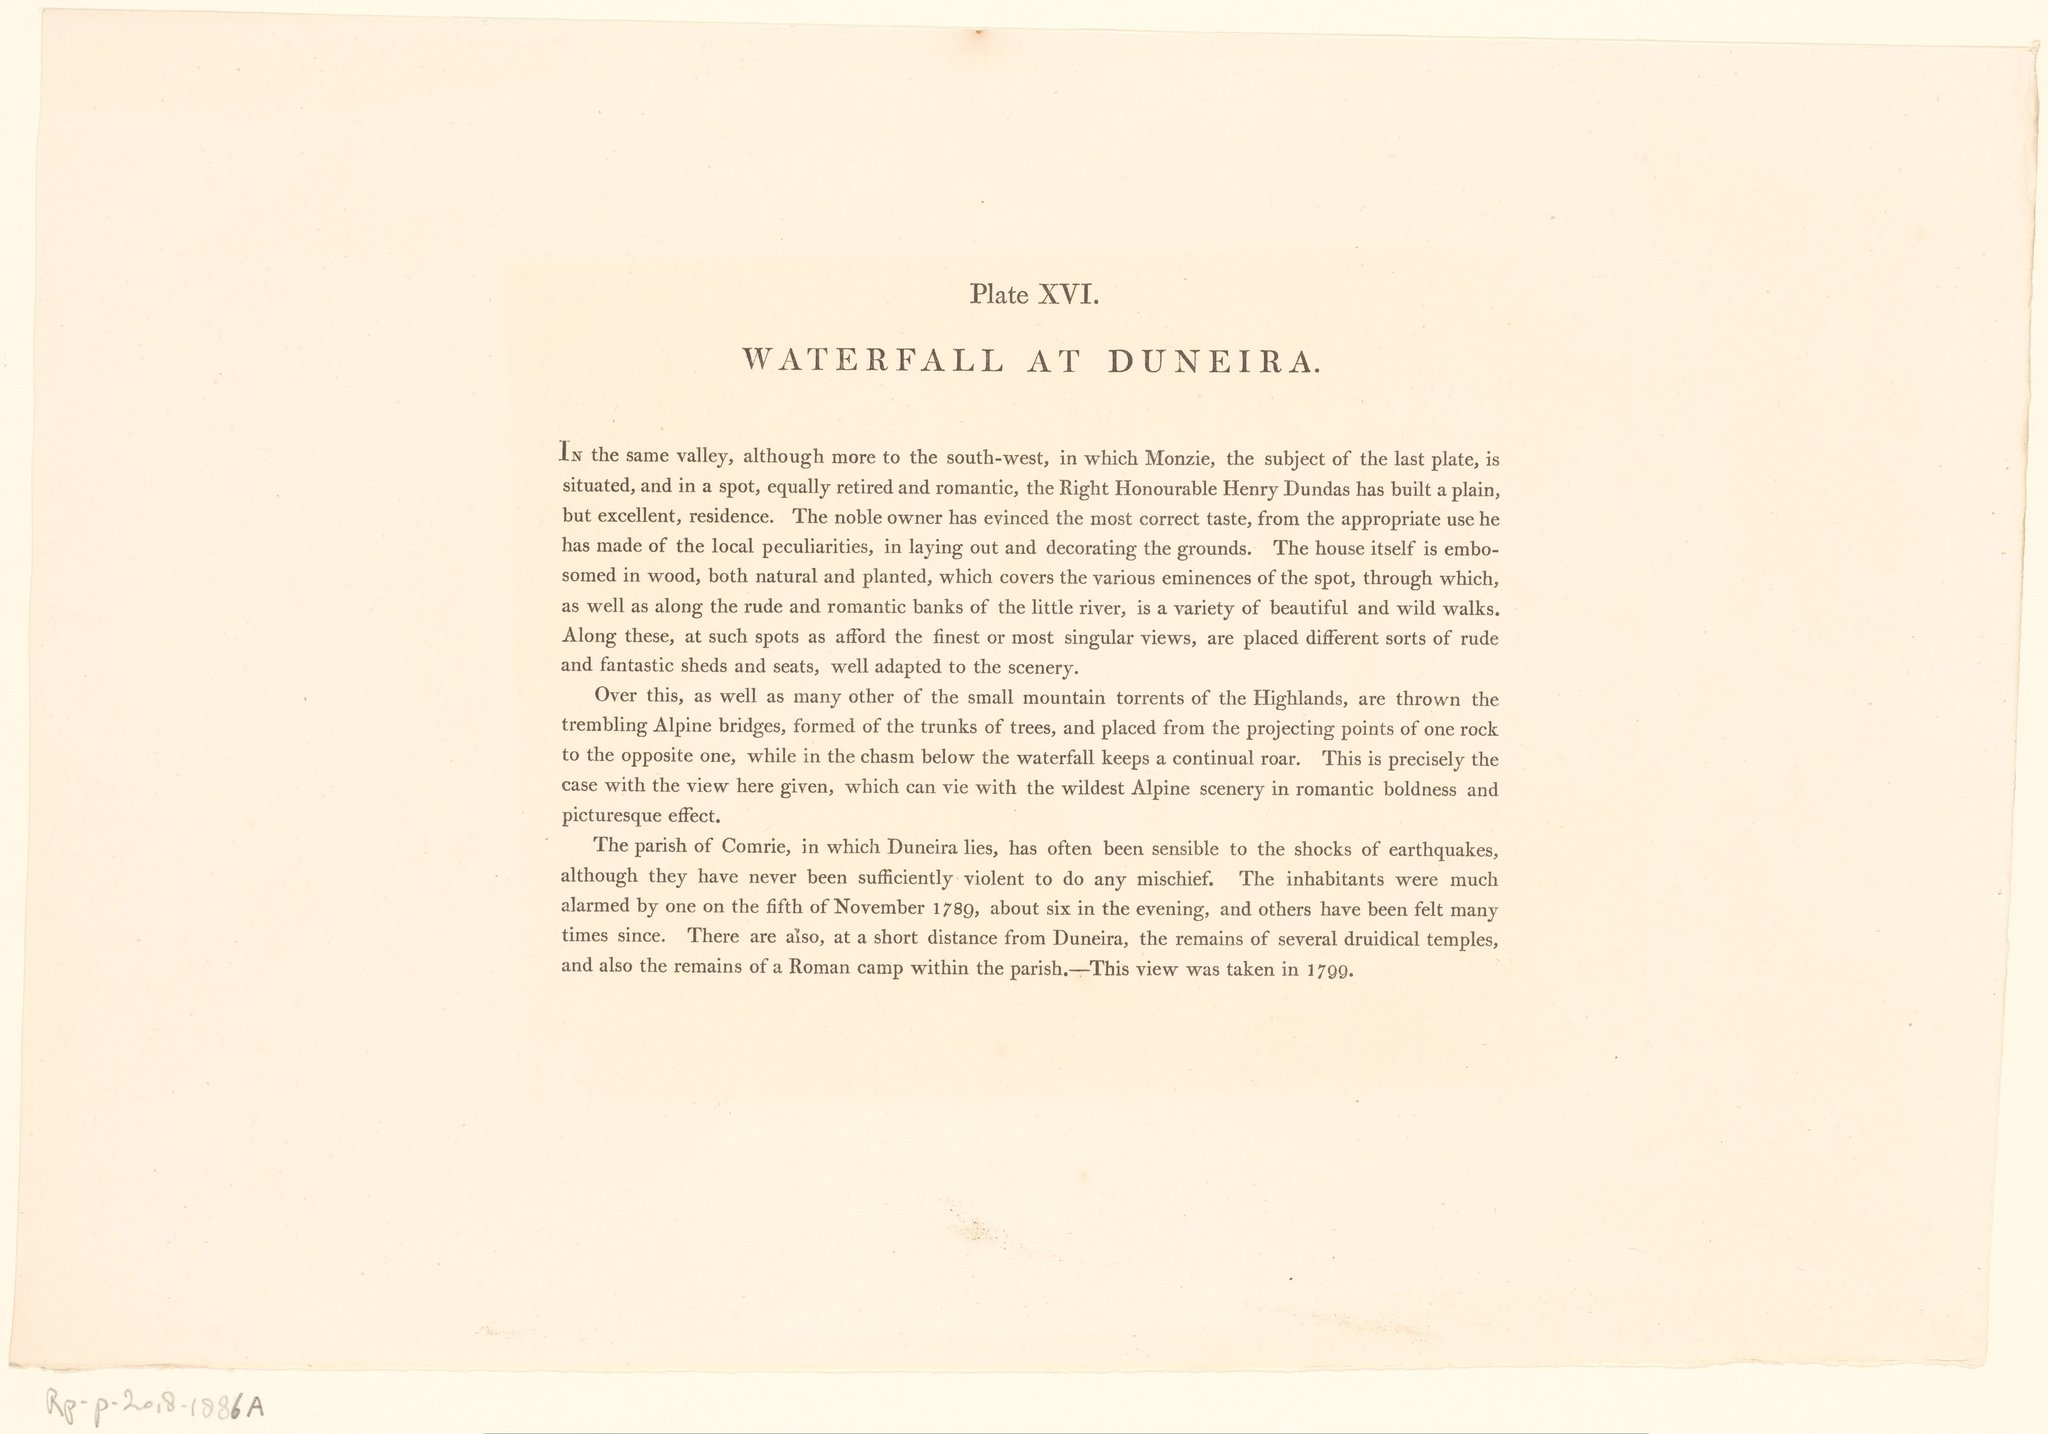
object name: text sheet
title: Plate XVI. Waterfall at Duneira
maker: william miller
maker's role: bookseller, printer, publisher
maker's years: 1769-1844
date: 1801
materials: paper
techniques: letterpress printing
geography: london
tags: schotland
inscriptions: collector's mark: Lugt 2228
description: Tekstblad gebruikt in: Scotia Depicta; or the antiquities, castles, public buildings, noblemen (...). Londen: William Miller, 1801.